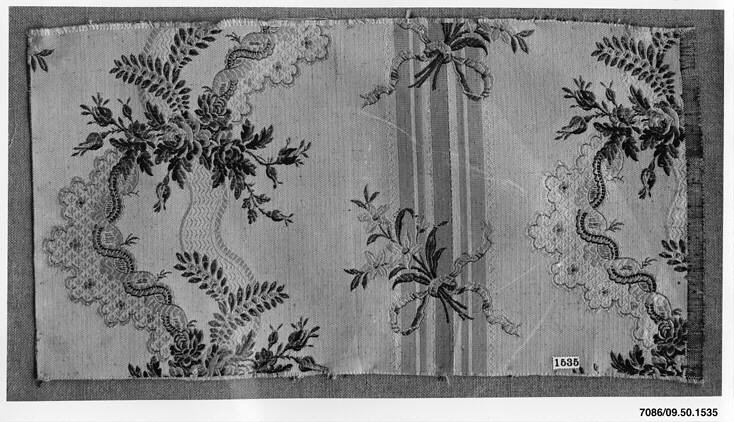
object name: piece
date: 1765-1770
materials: silk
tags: leaves